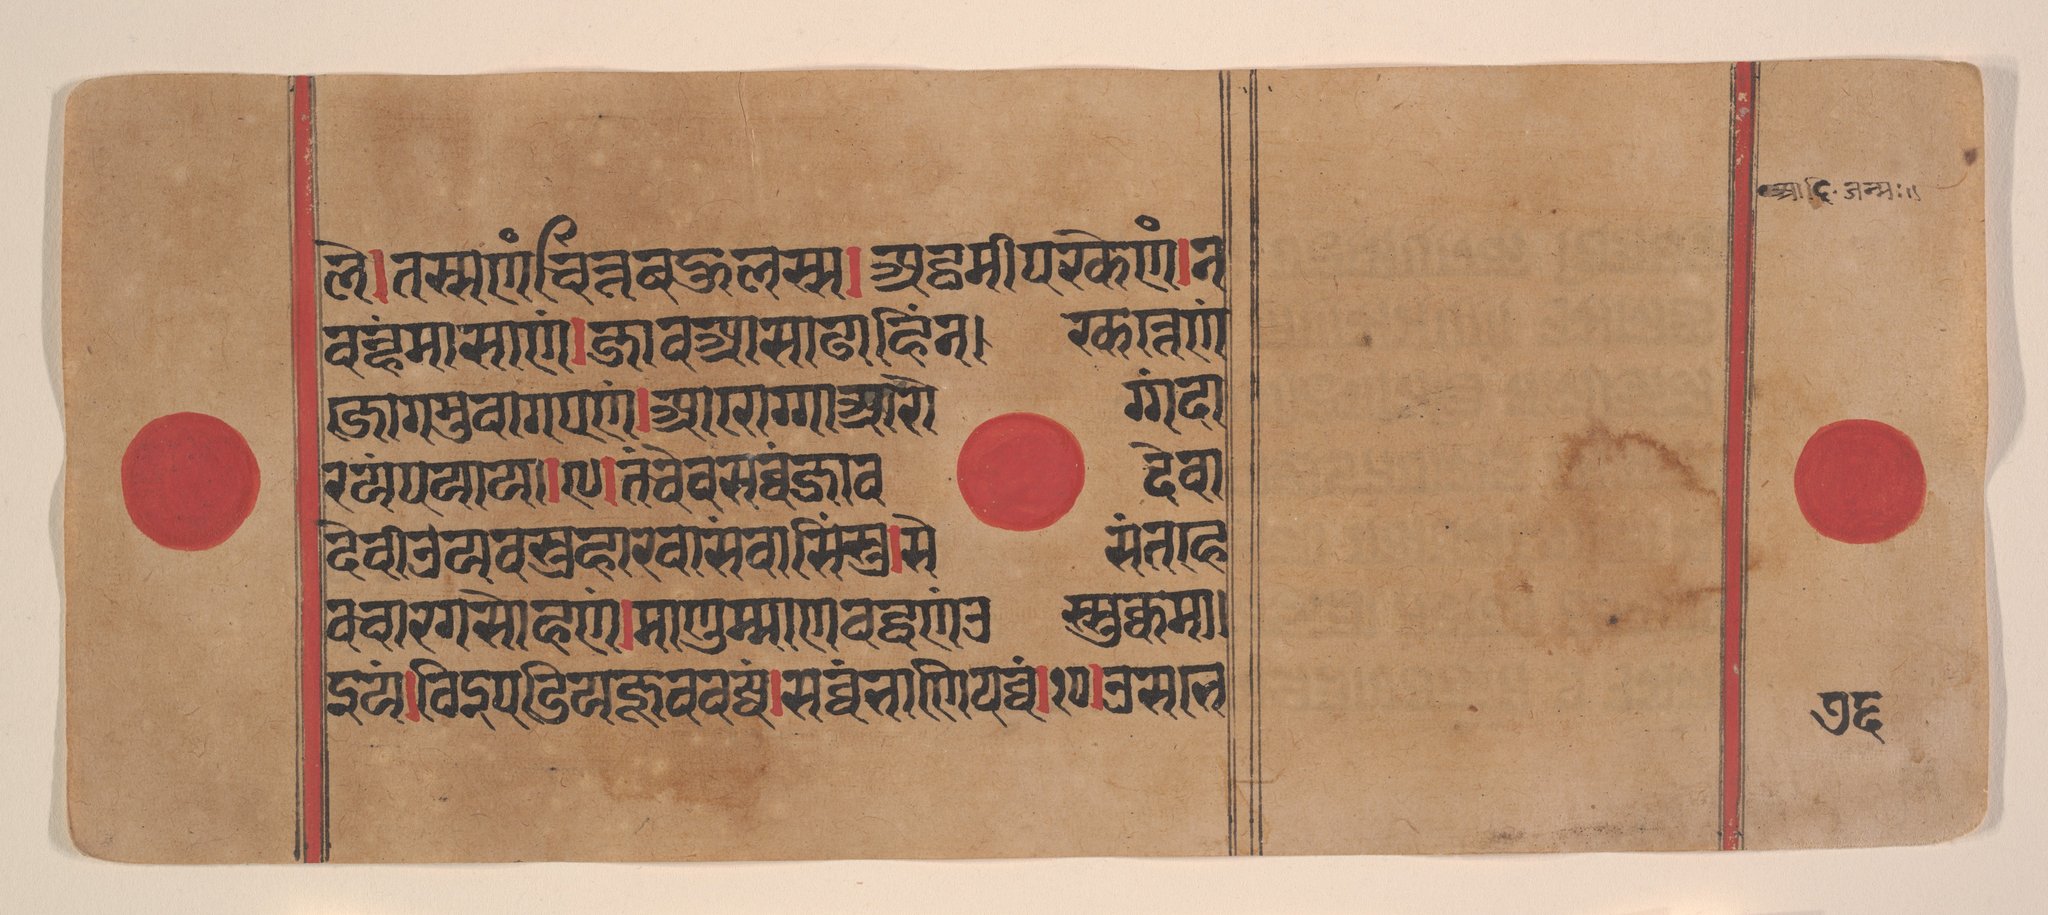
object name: folio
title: Page from a Dispersed Kalpa Sutra (Jain Book of Rituals)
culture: indian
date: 1401-1500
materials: gold, ink, paper, watercolor